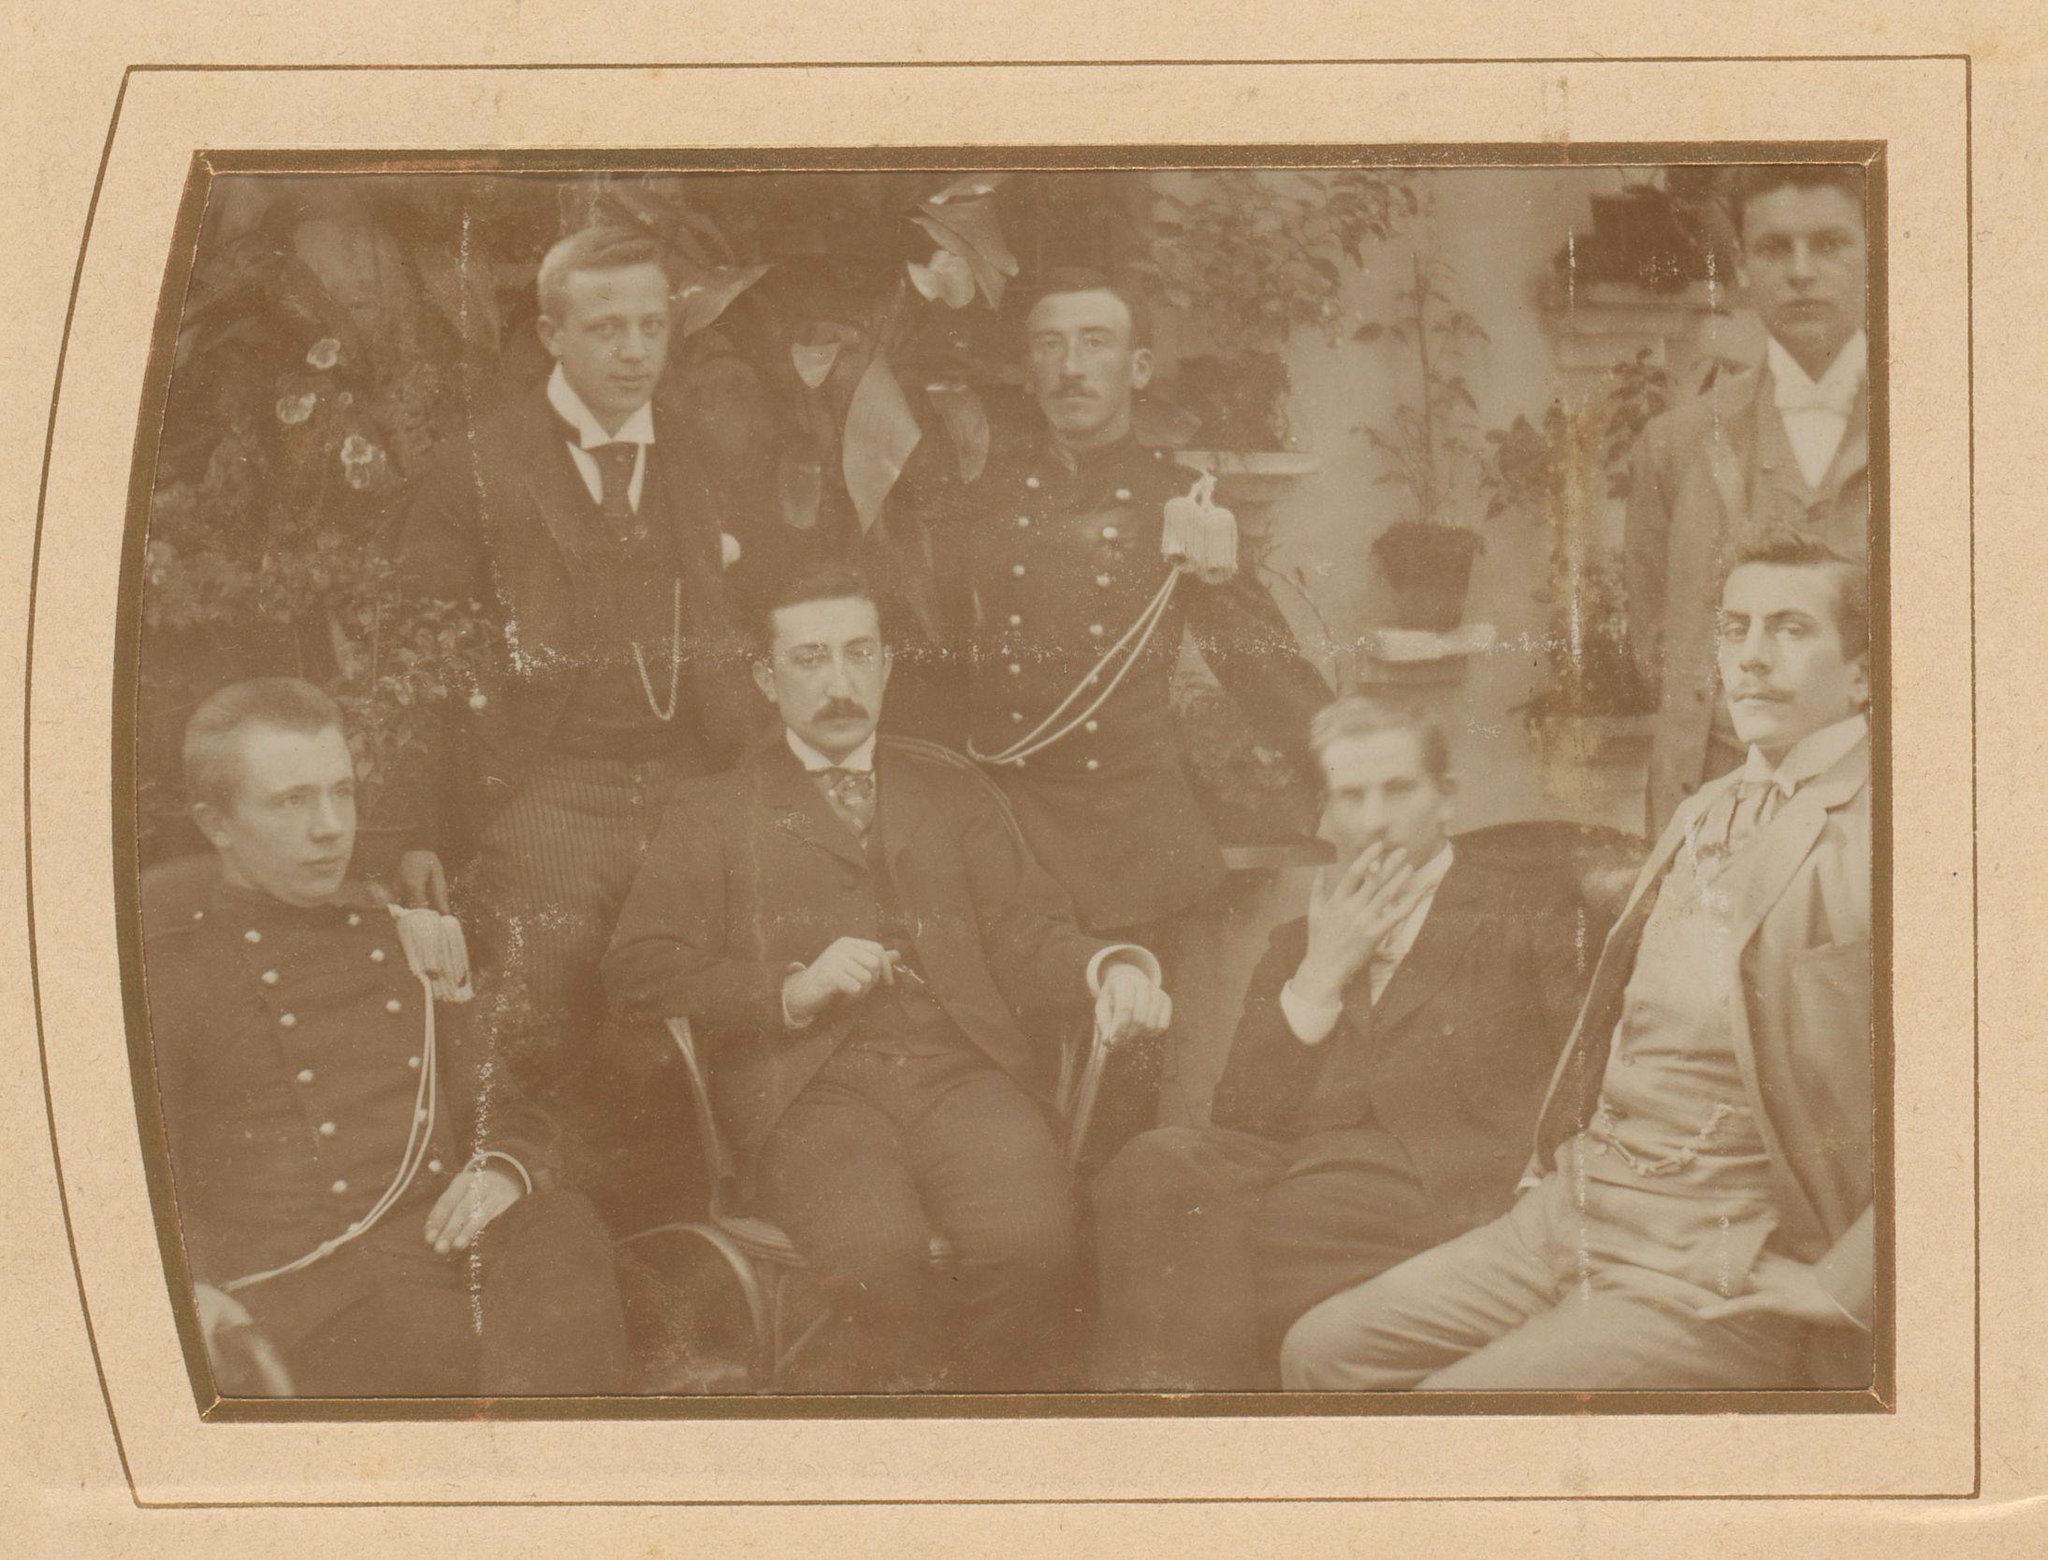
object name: album leaf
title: Groepsportret van studenten, met zittend in het midden François Buys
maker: Anonymous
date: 1880-1890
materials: paper, cardboard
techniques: collodion silver print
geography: amsterdam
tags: françois buys, historical persons, student life, anonymous historical persons portrayed in a group, in a group-portrait